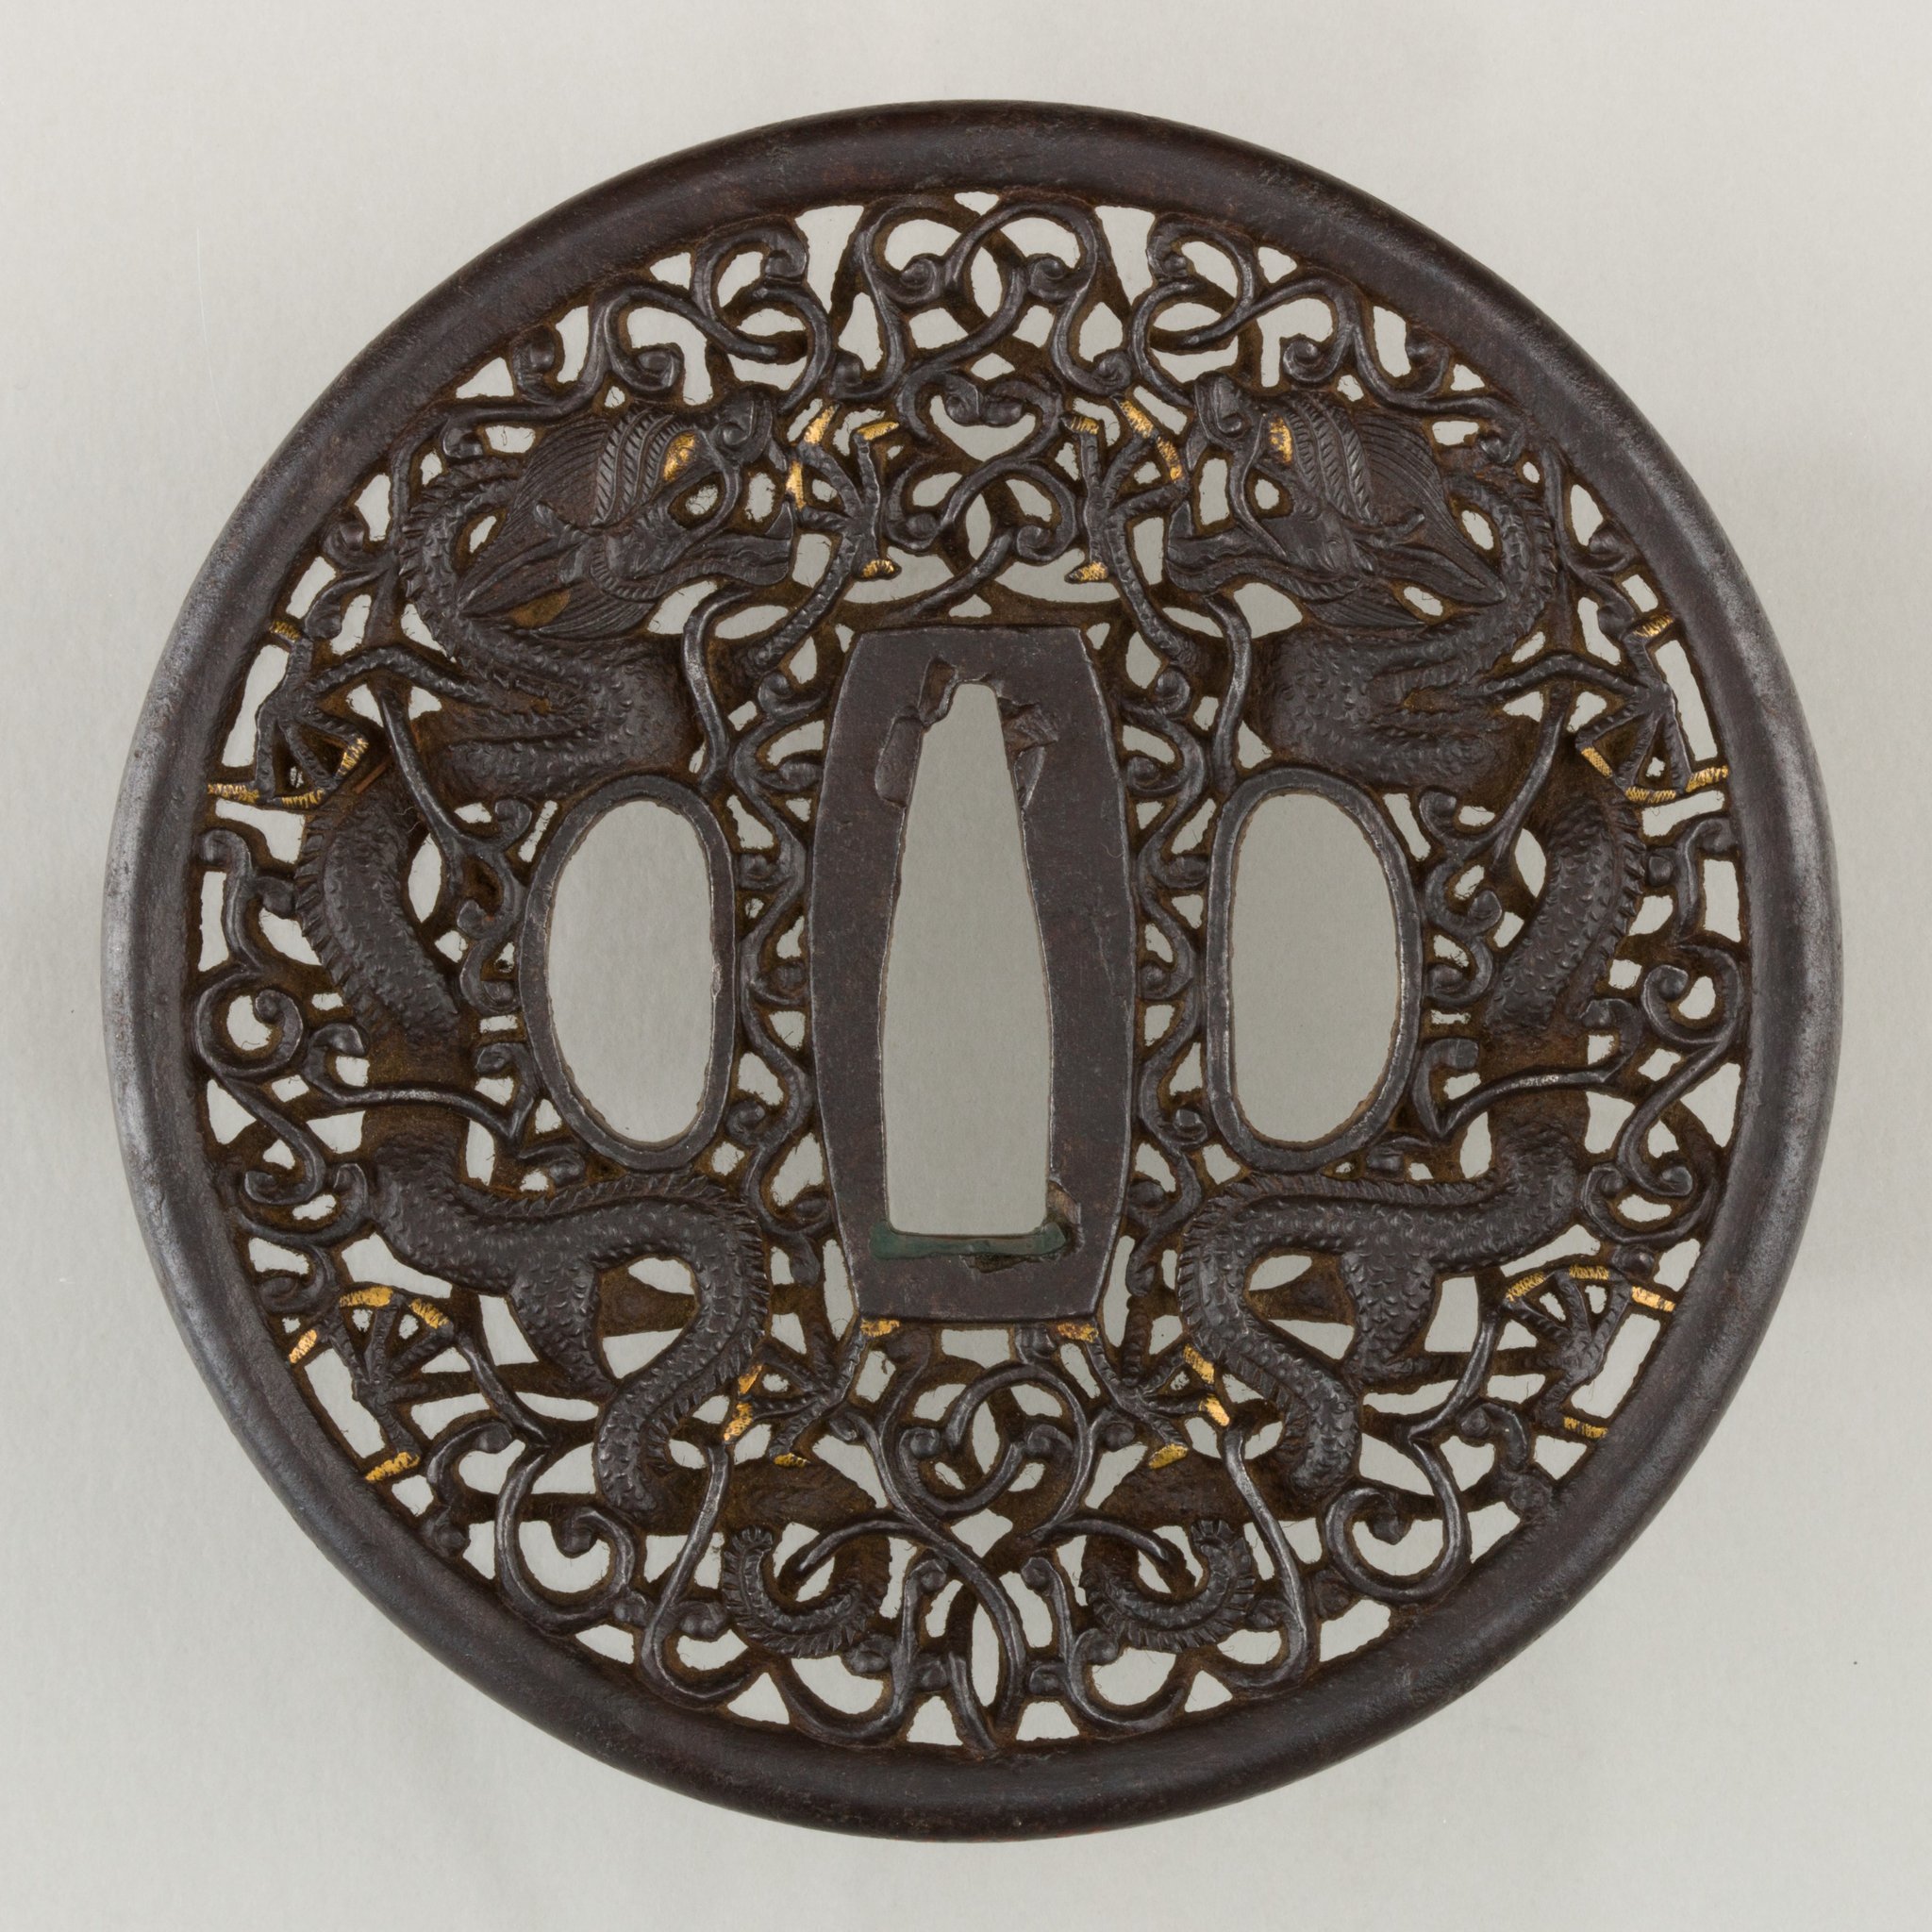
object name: sword guard tsuba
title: Sword Guard (Tsuba)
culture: japanese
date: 1701-1733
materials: copper, gold, iron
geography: japan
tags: dragons